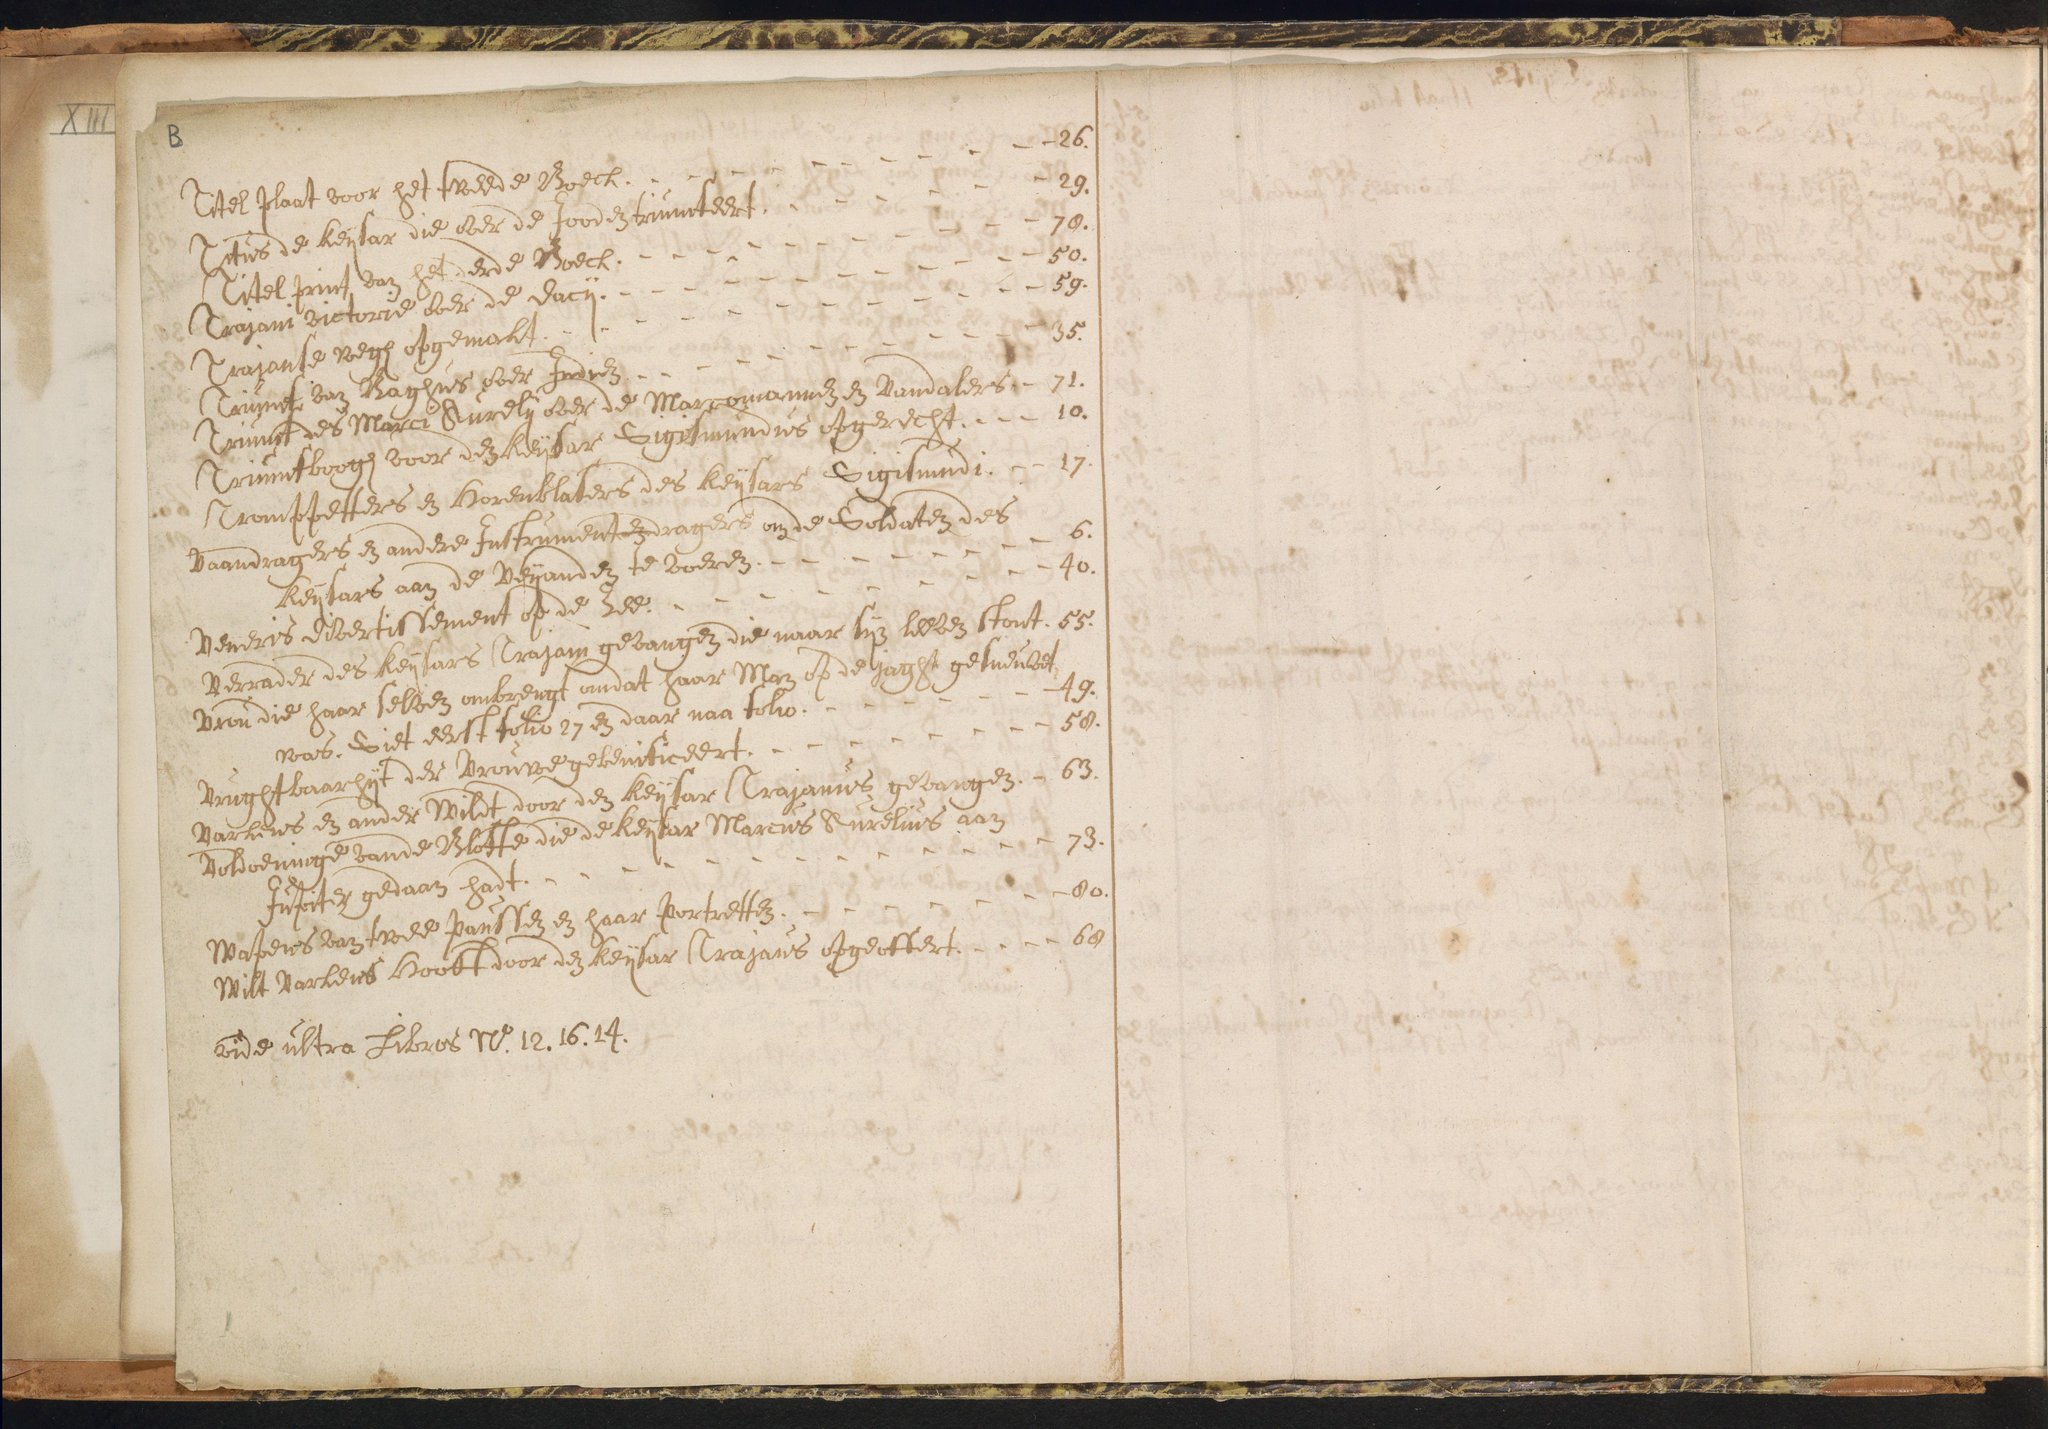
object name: album leaf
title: Handgeschreven inventaris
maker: michiel hinloopen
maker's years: 1619-1708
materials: paper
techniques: pen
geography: amsterdam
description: Inventaris maakt deel uit van een album.